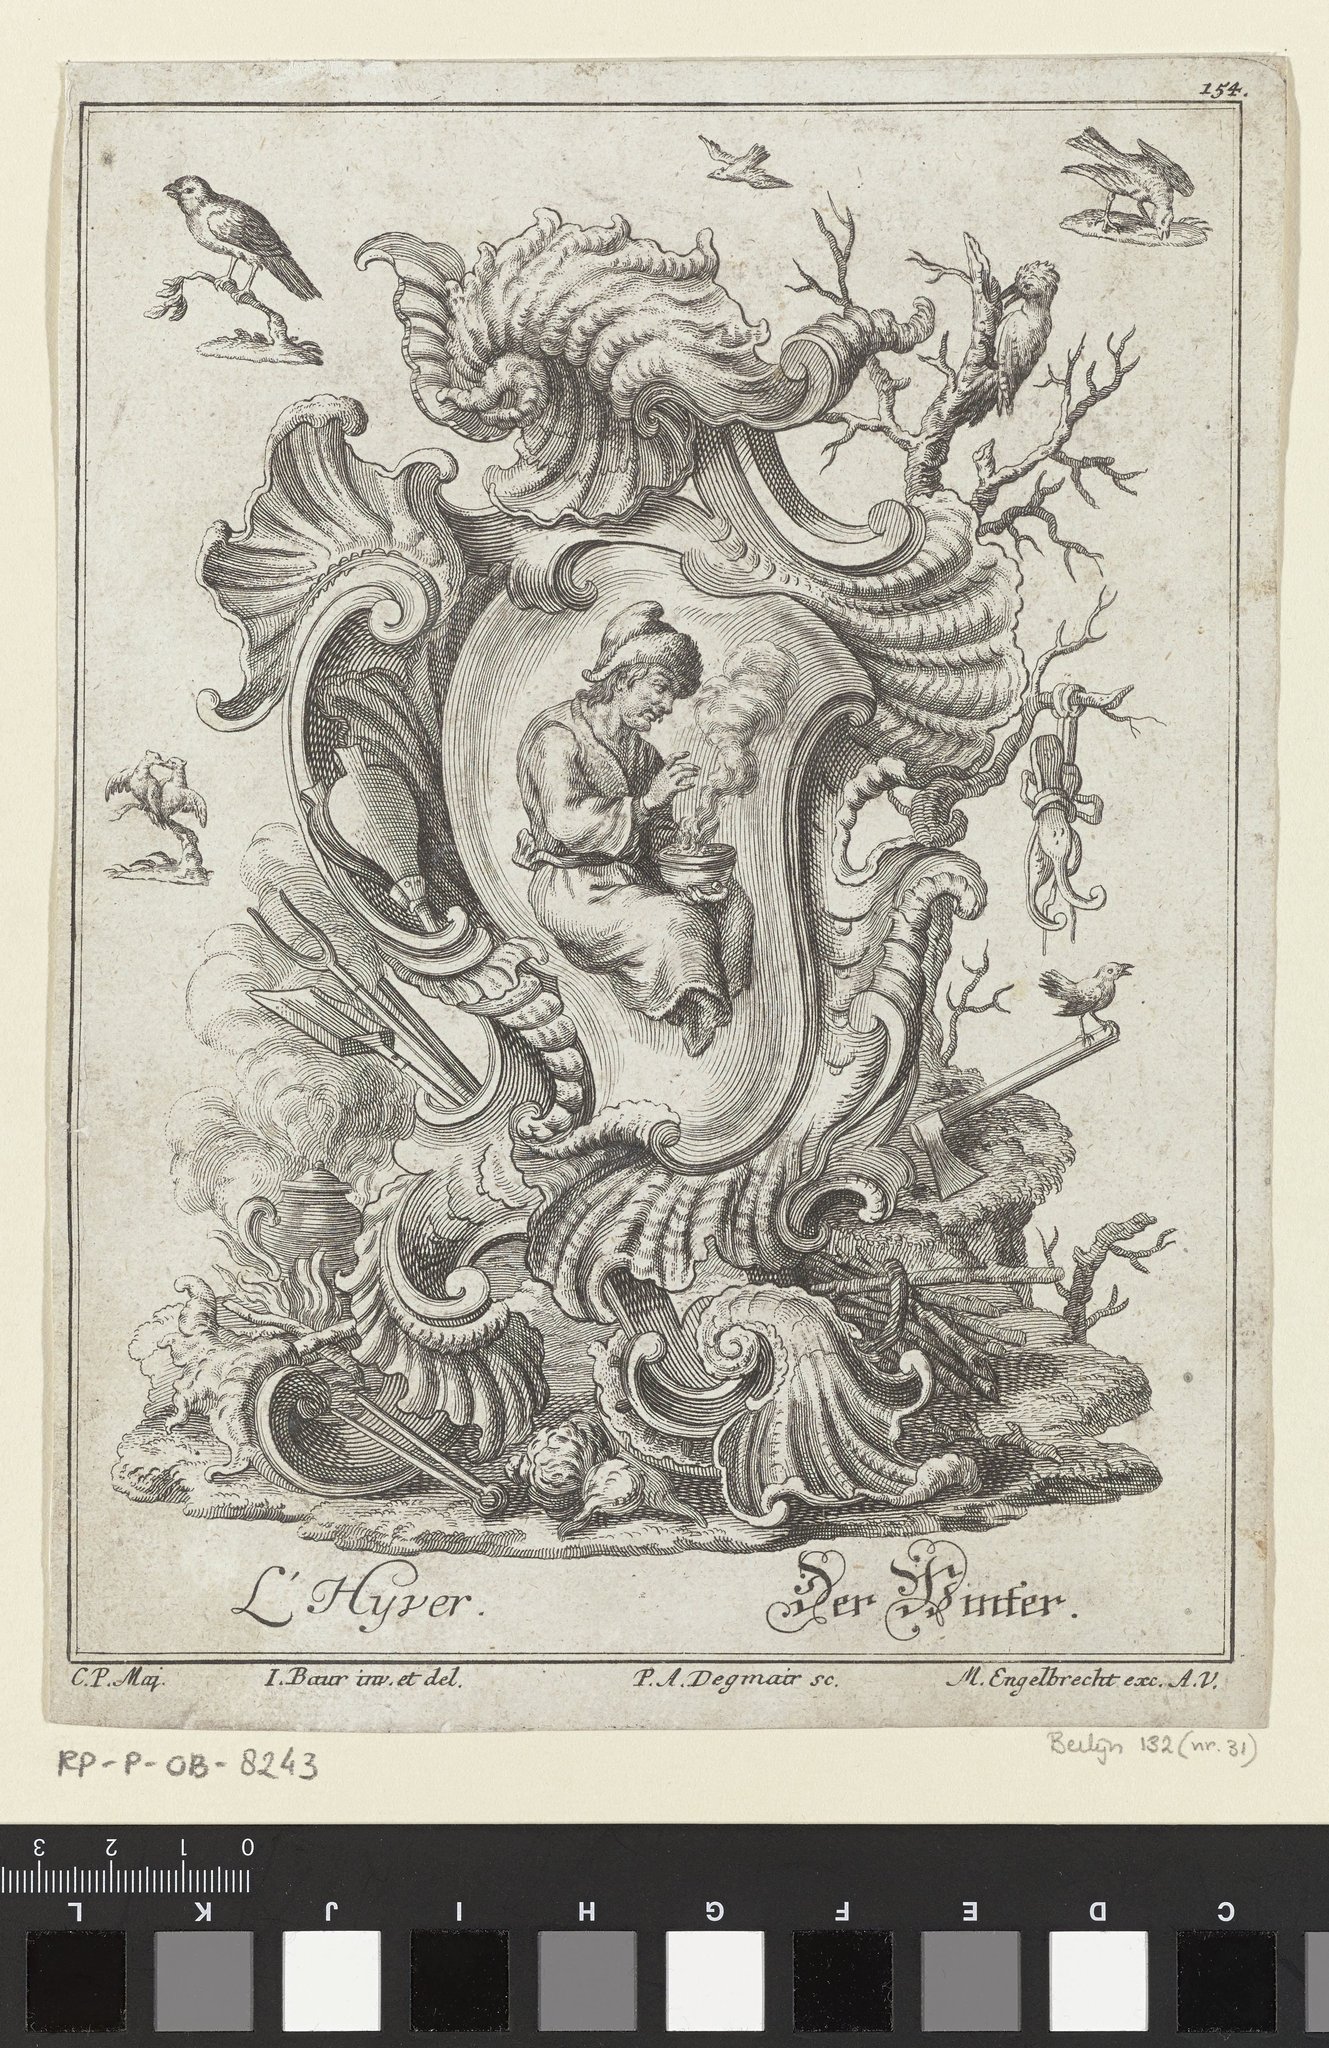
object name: ornament print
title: De vier seizoenen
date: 1719-1749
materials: paper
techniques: etching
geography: augsburg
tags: rocaille ornament, birds, winter, 'hyems'; 'inverno' (ripa), skates (winter sports)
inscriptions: collector's mark: Lugt 2228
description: Op een rocaille is een man met een vuurpot afgebeeld als personificatie van de winter. De rocaille is versierd met een blaasbalg, schaatsen en gereedschappen. Rondom vogels. Rechtsboven 154 genummerd.